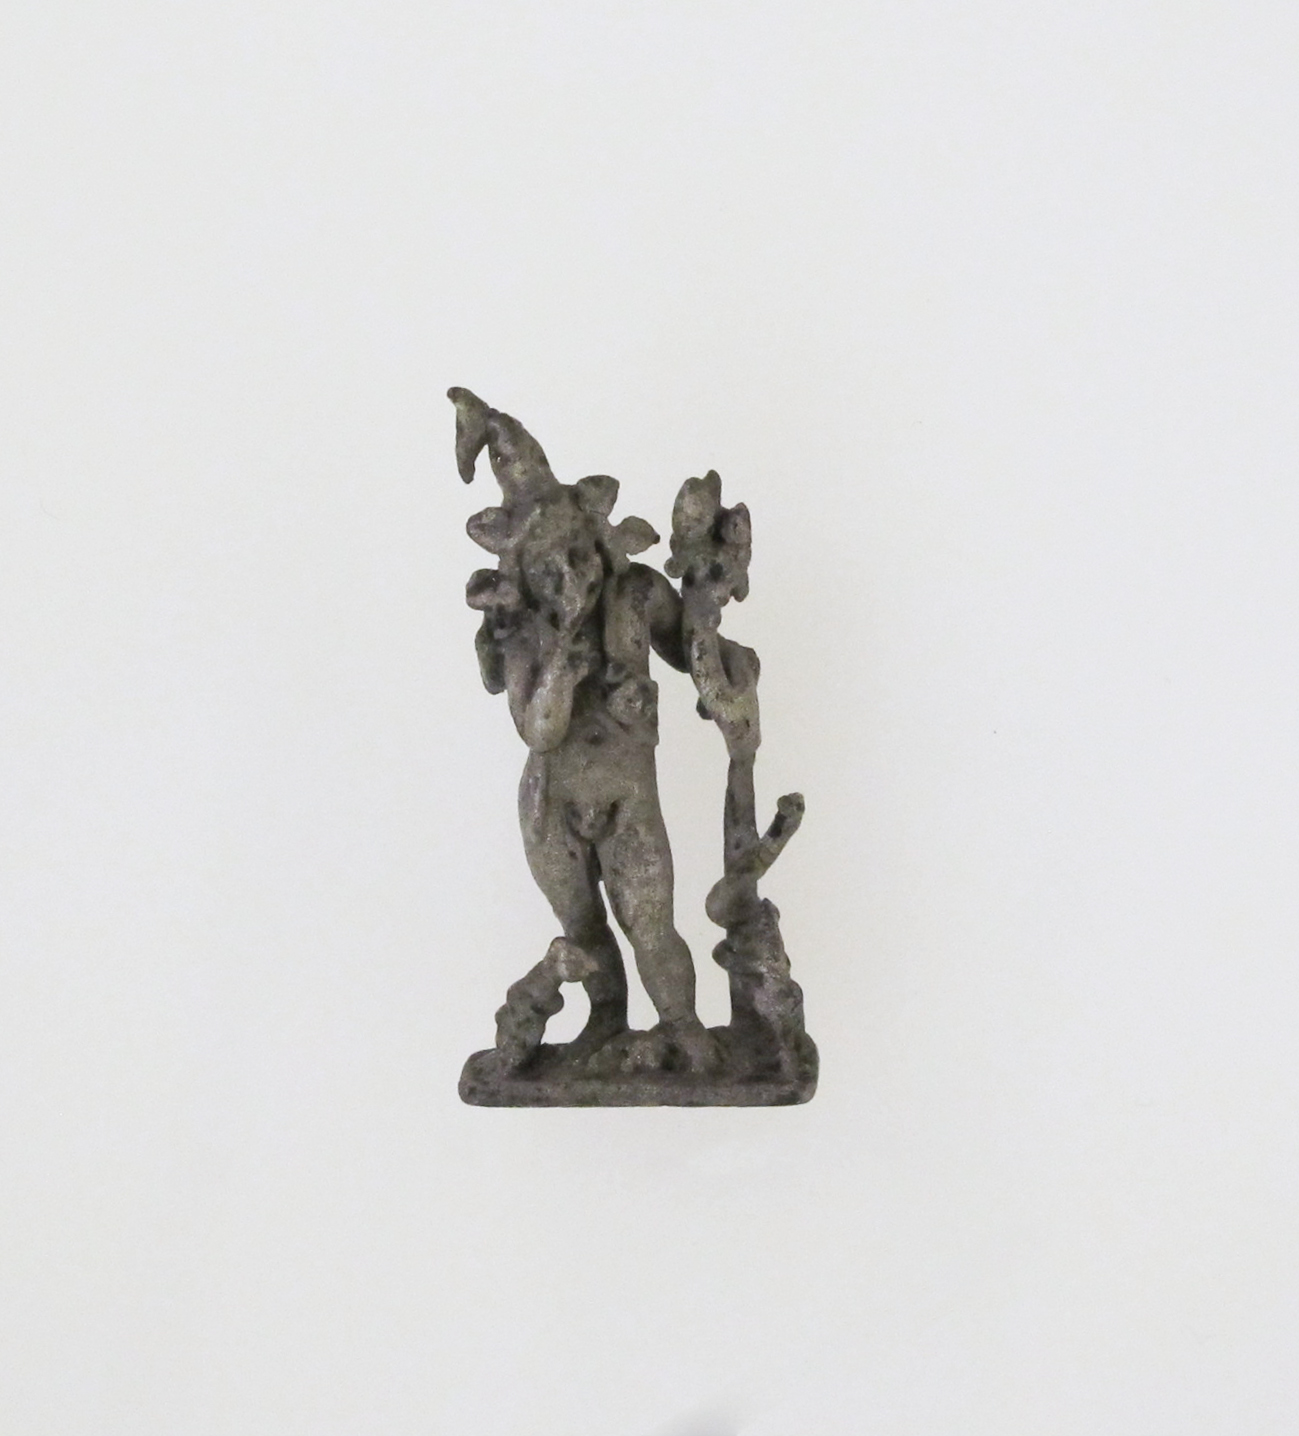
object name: statuette, harpokrates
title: Statuette of Harpokrates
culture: roman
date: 100 BCE-100 CE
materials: silver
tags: harpokrates